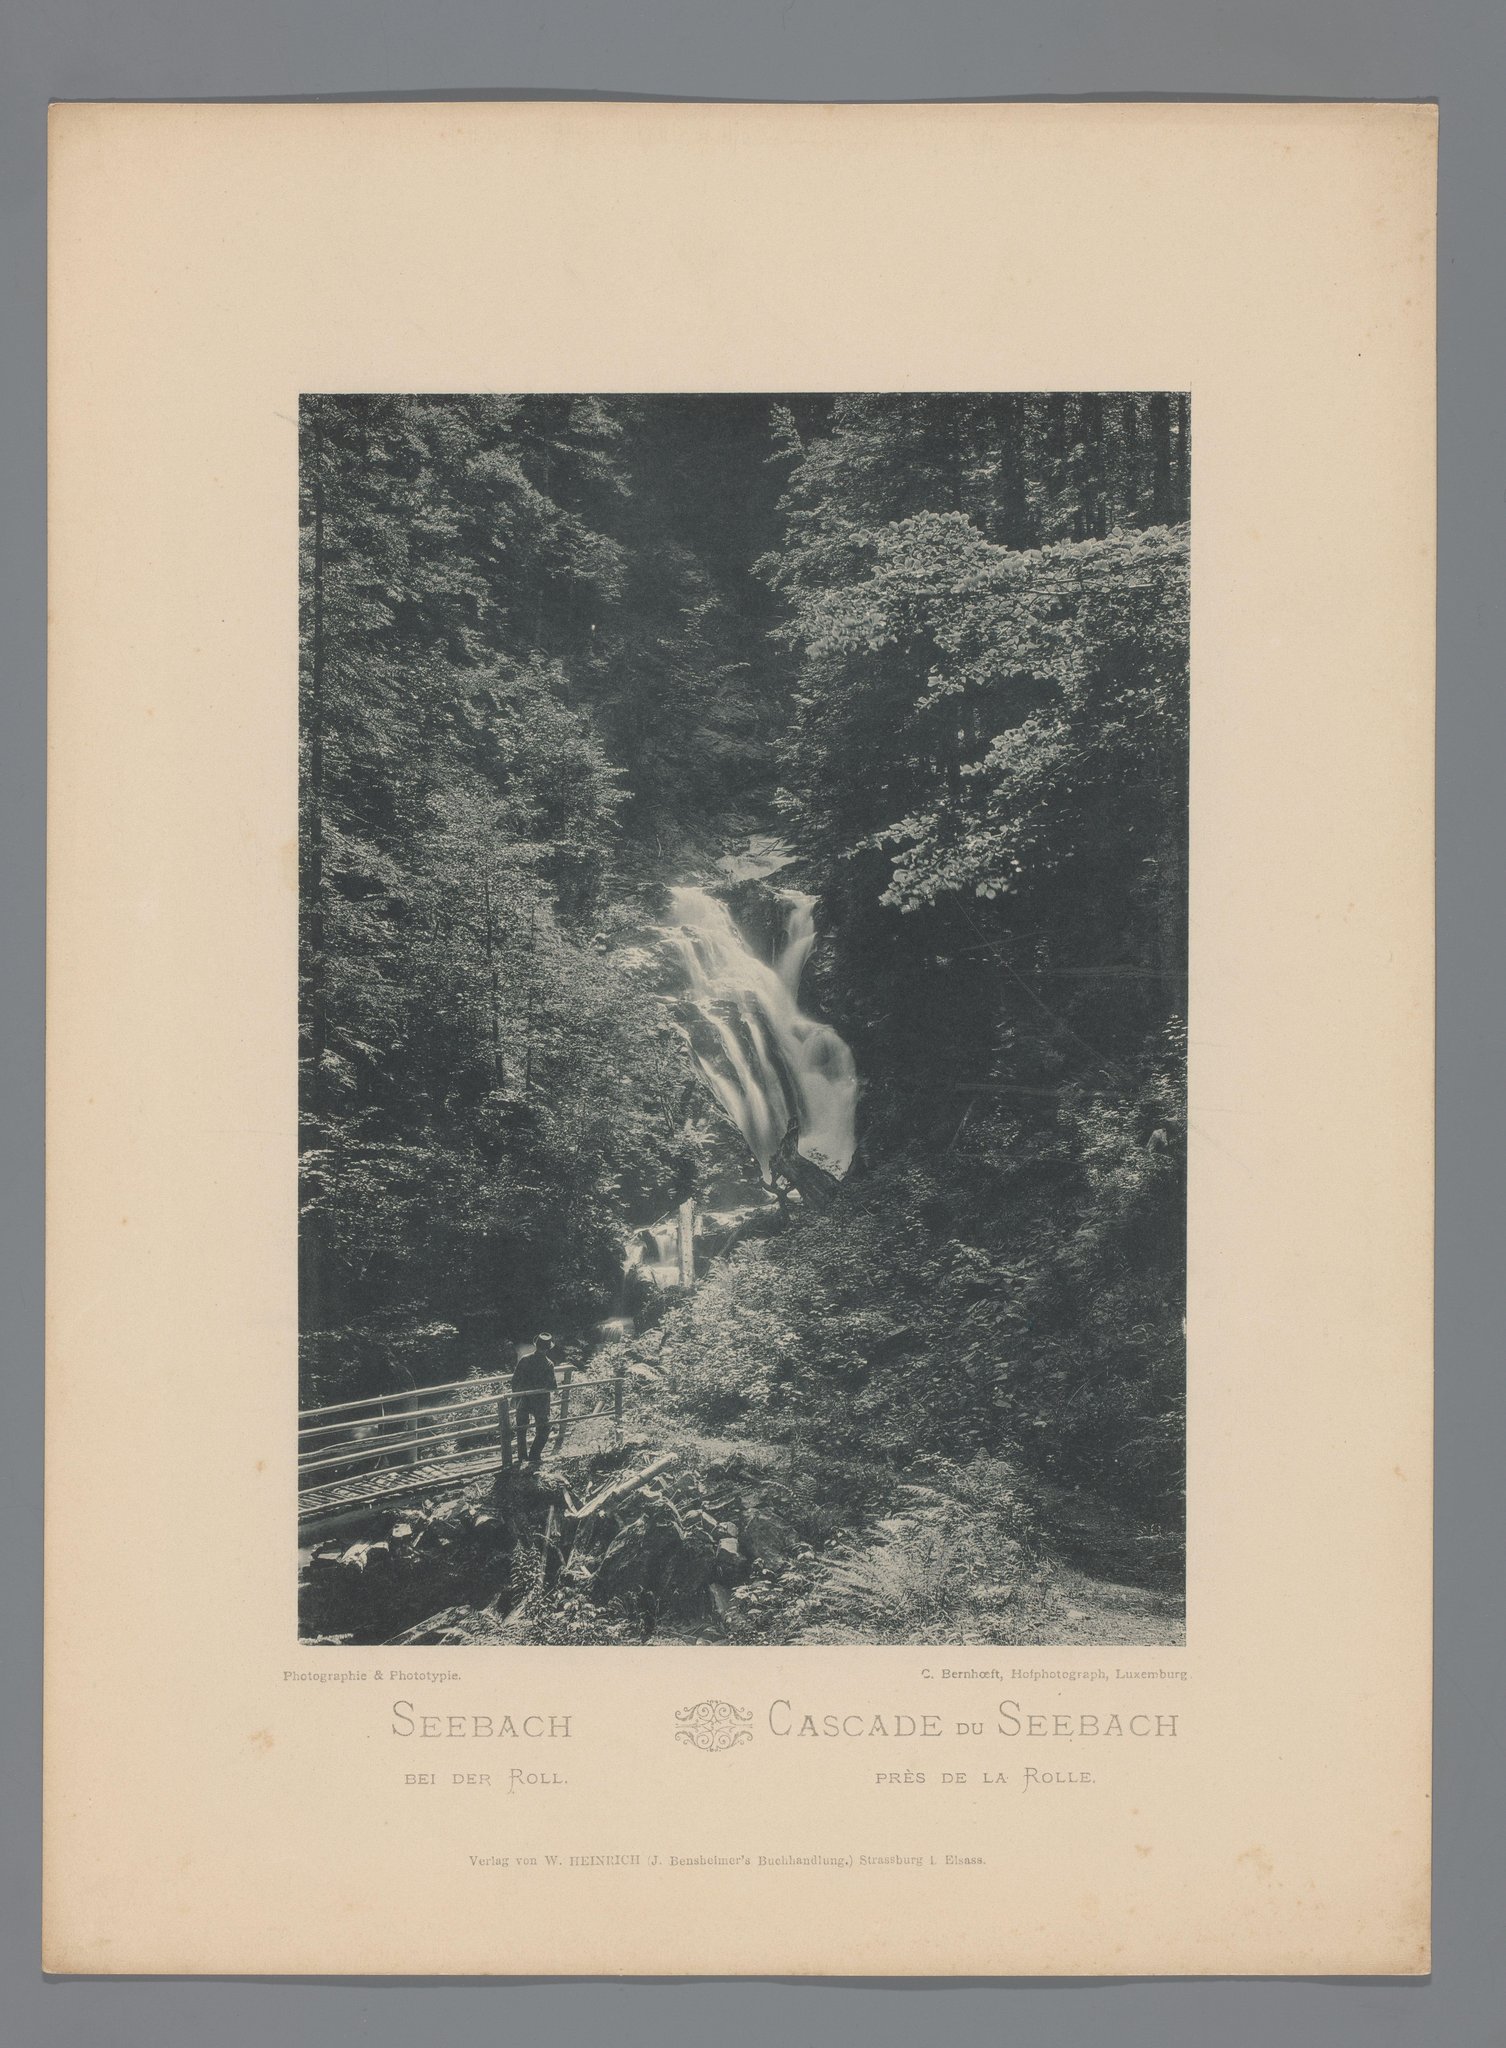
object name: page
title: Waterval bij Seebach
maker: charles bernhoeft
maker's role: publisher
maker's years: 1859-1933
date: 1889-1894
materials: paper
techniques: photograph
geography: straatsburg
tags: waterfall (+ landscape with figures, staffage)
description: Deze prent maakt deel uit van een omslag met 100 prenten.